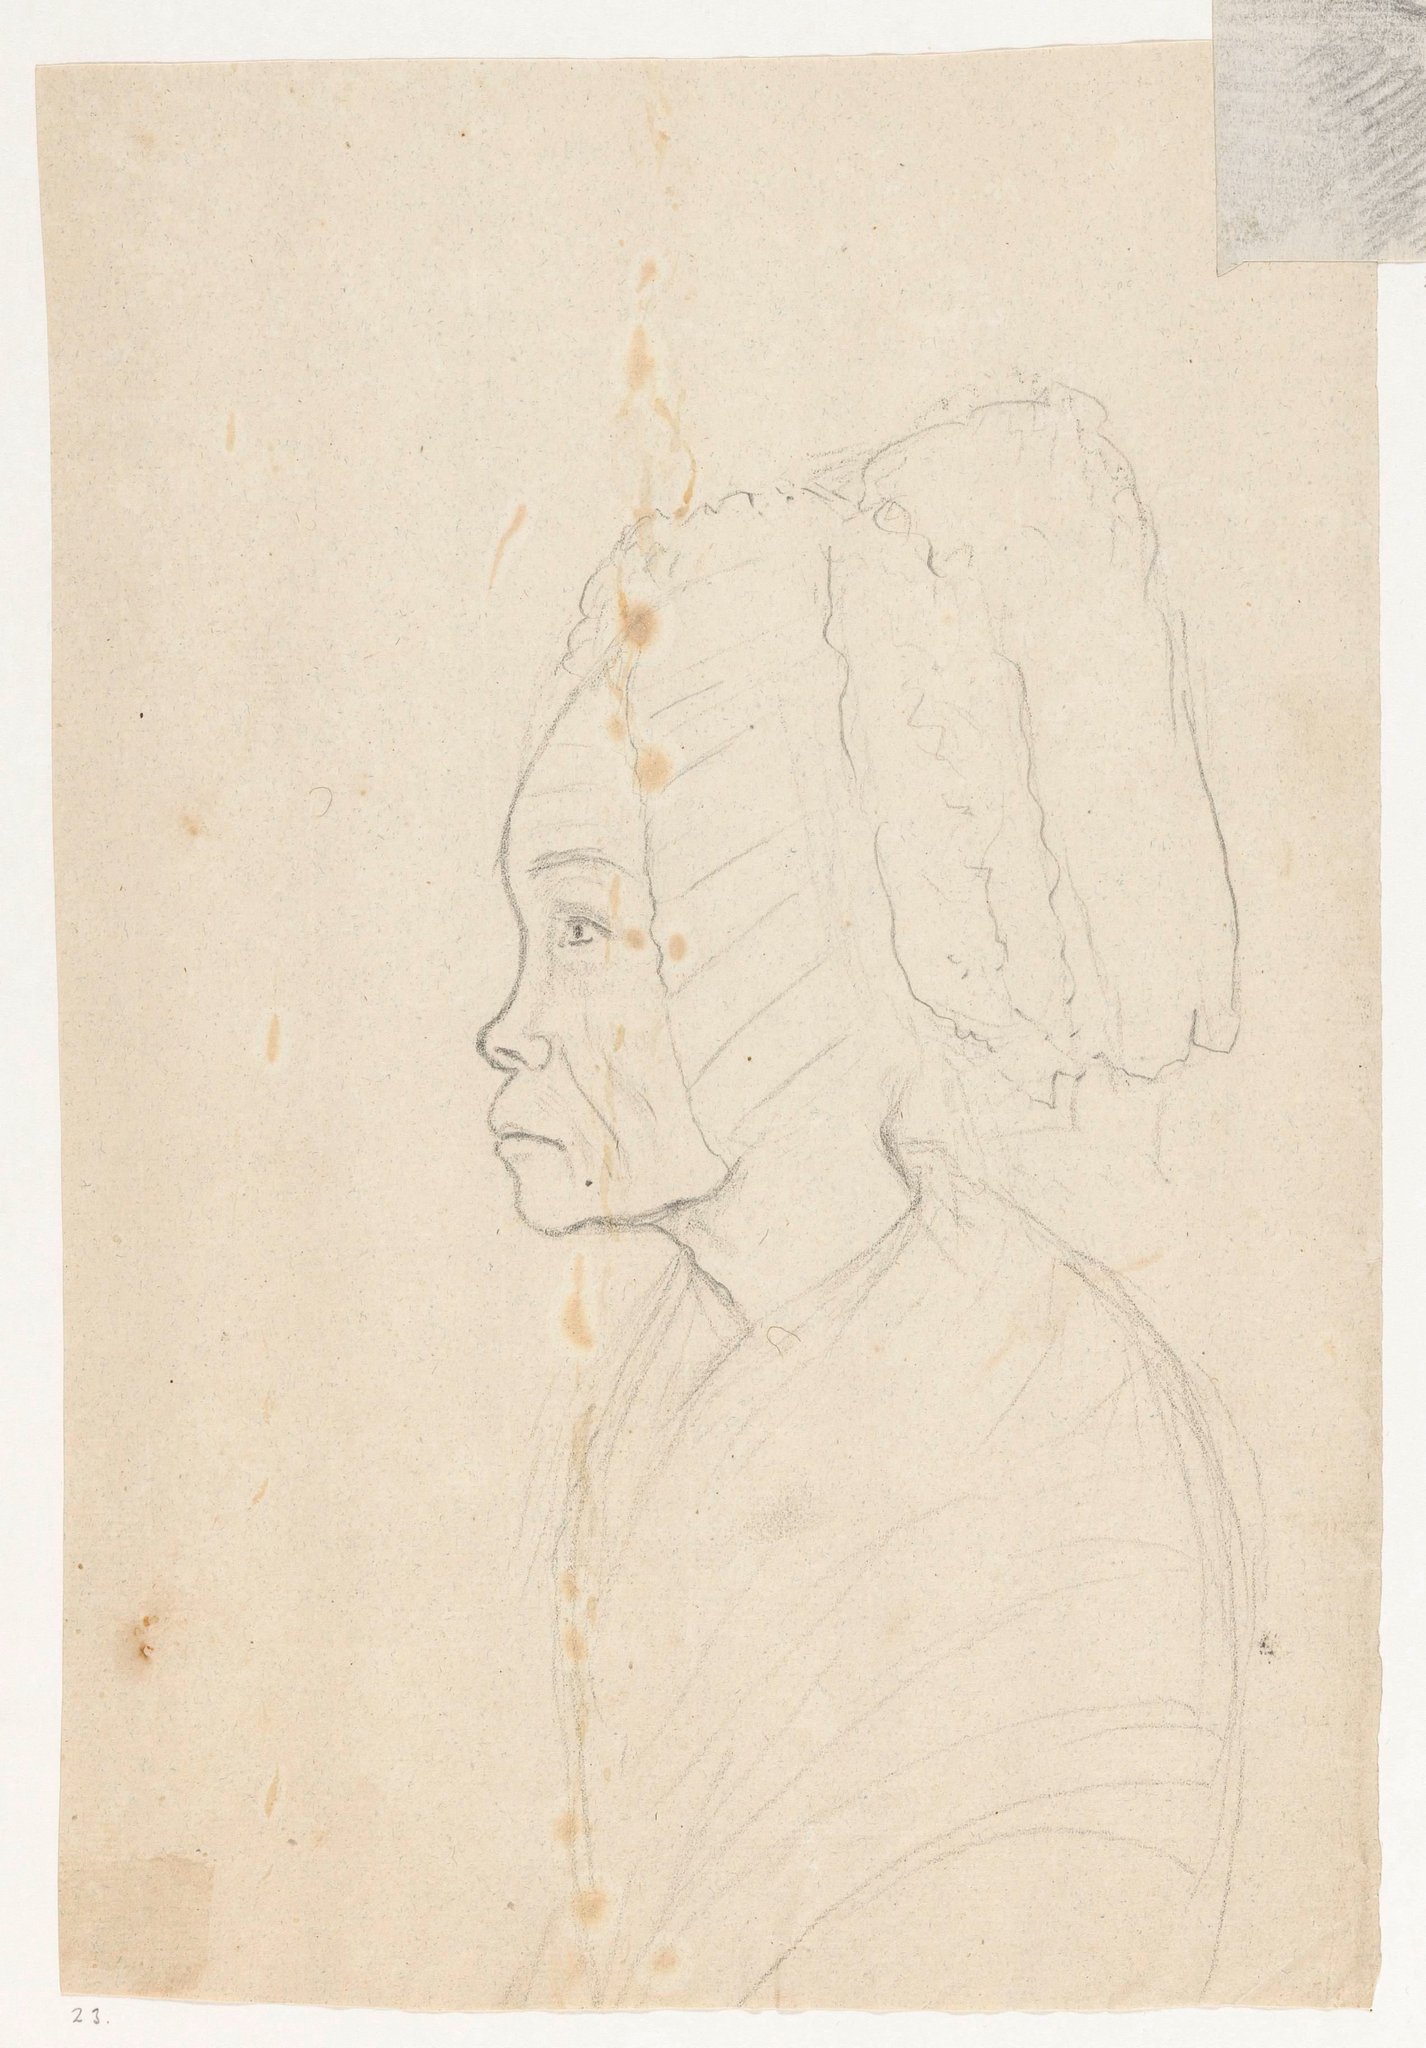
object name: drawing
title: Oude Javaanse vrouw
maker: jan brandes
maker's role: draughtsman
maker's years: 1743-1808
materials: paper, pencil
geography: batavia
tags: historical persons - bb - woman, java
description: Portret van een oude Javaanse vrouw. In profiel naar links, met een hoed of kap op het hoofd.